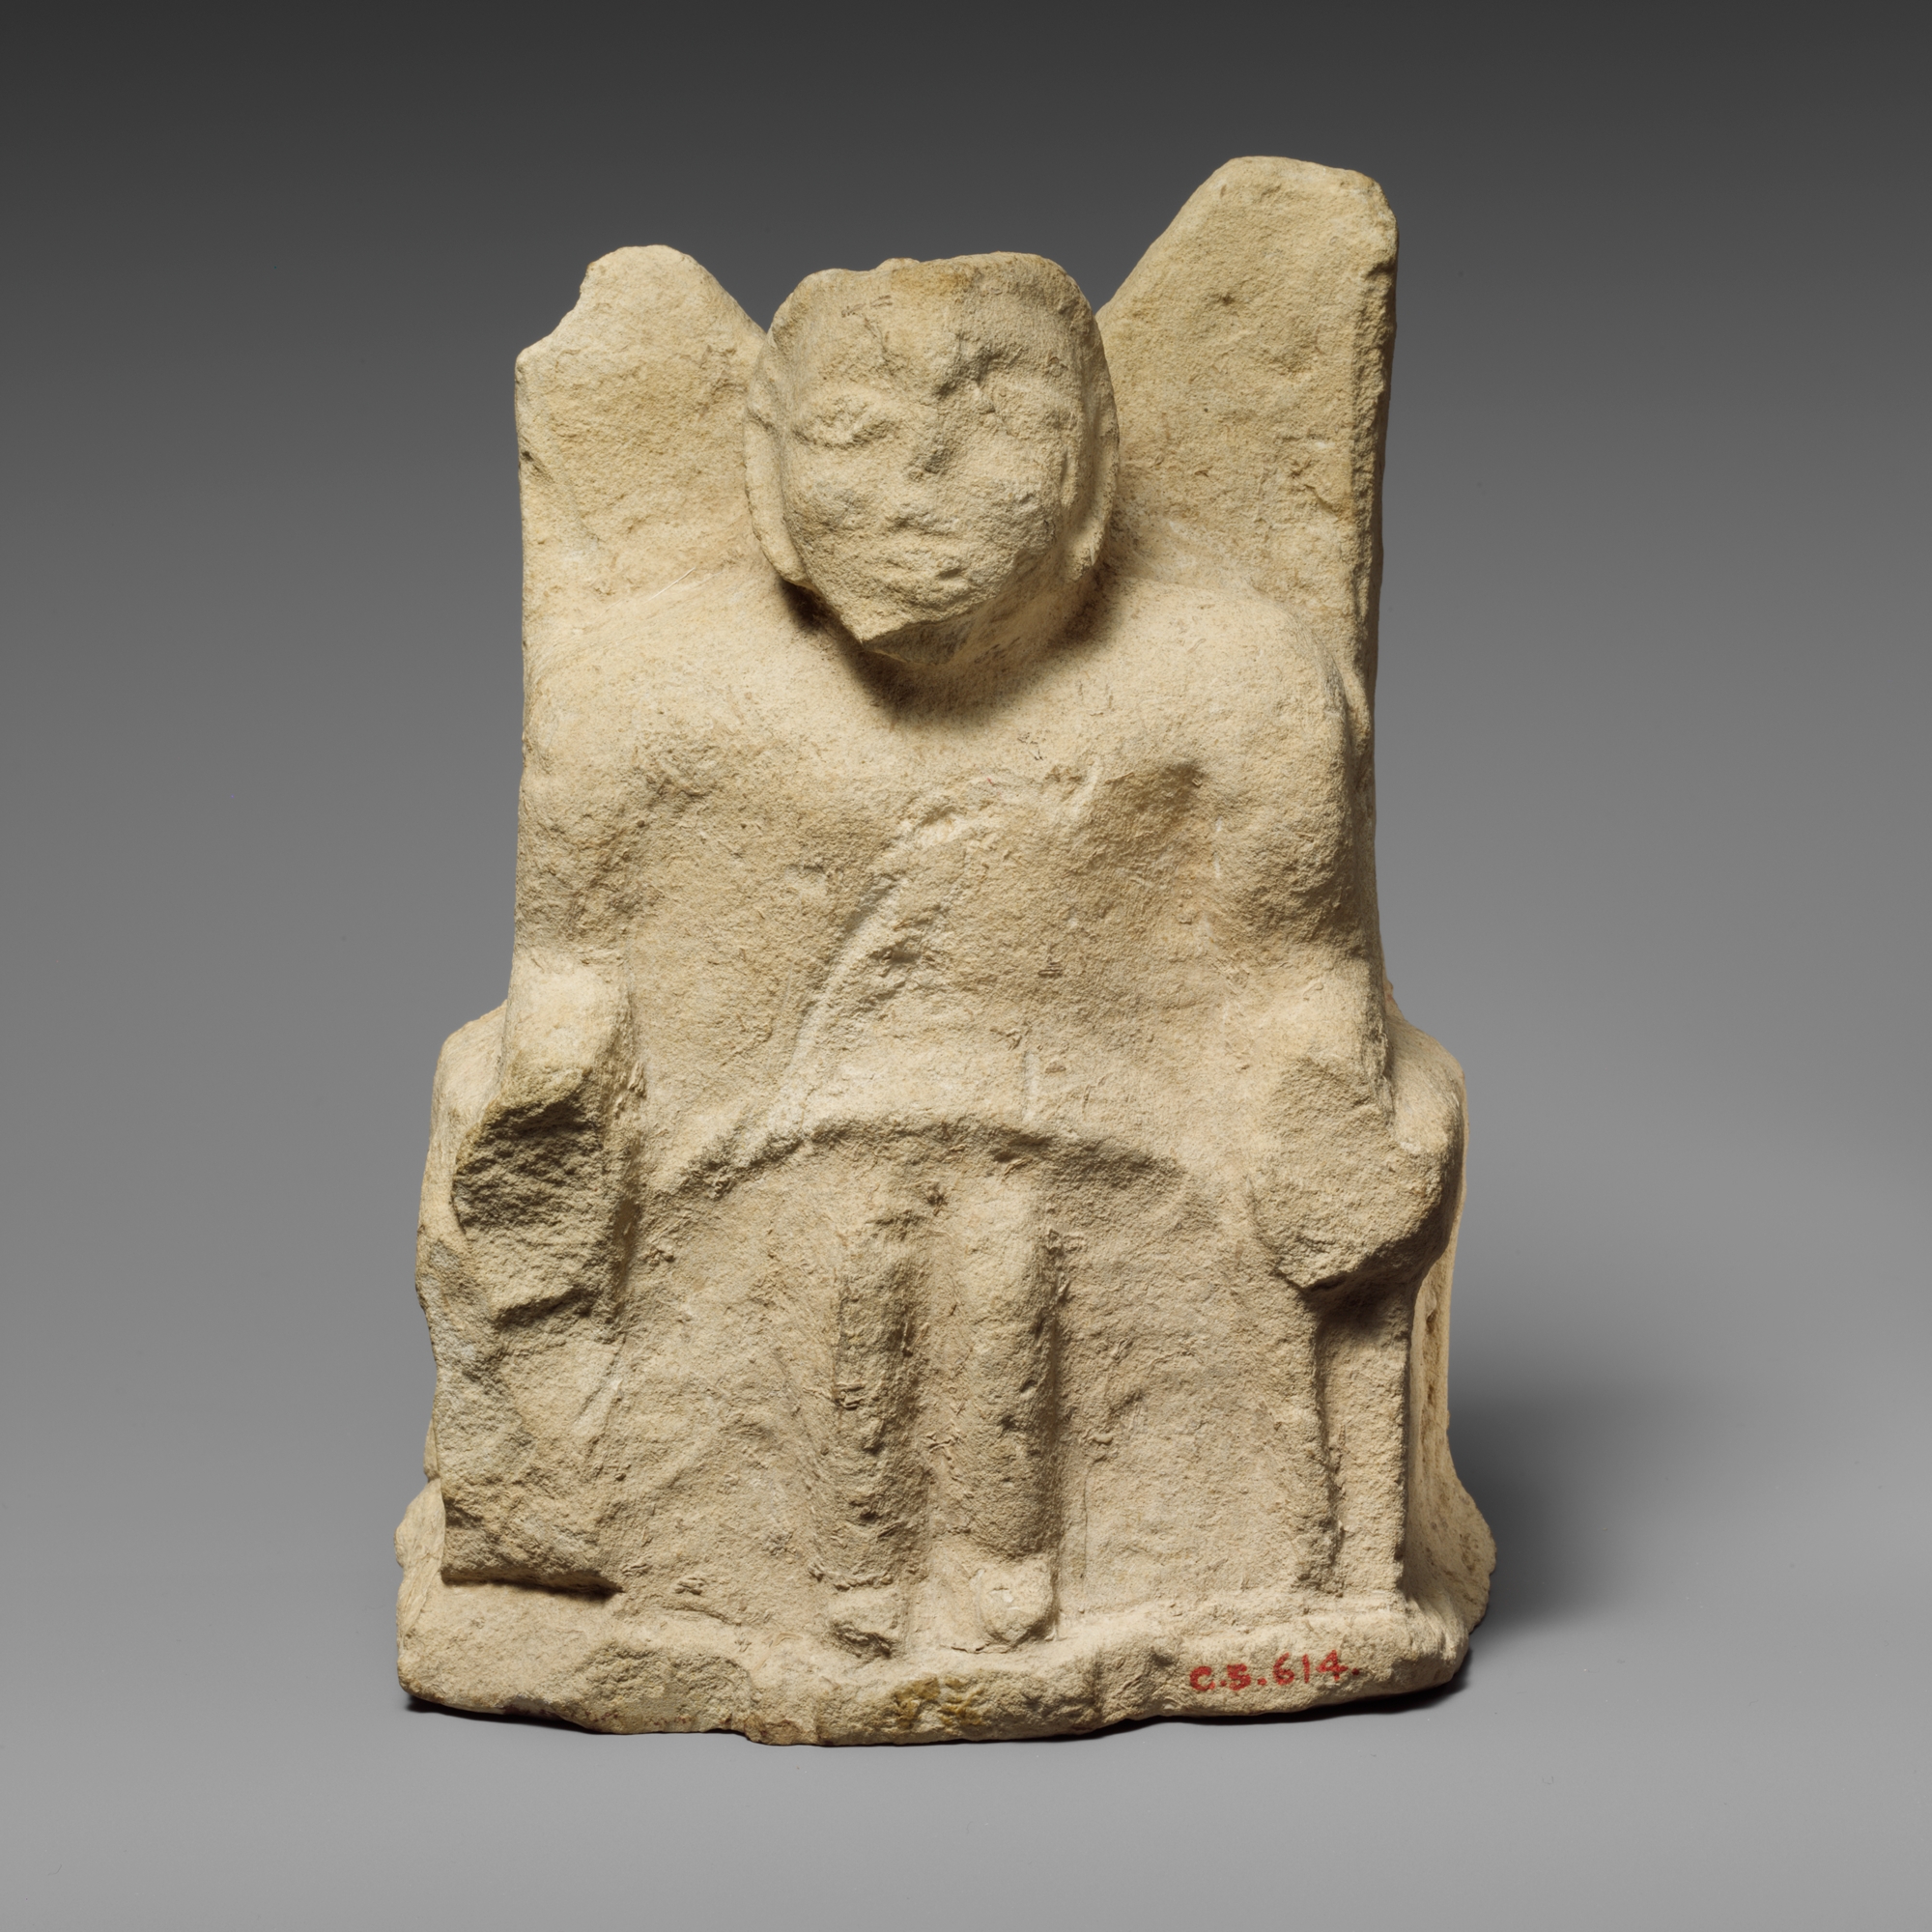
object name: statuette of zeus ammon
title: Limestone statuette of a seated Zeus Ammon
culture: cypriot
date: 400-301 BCE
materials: limestone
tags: zeus